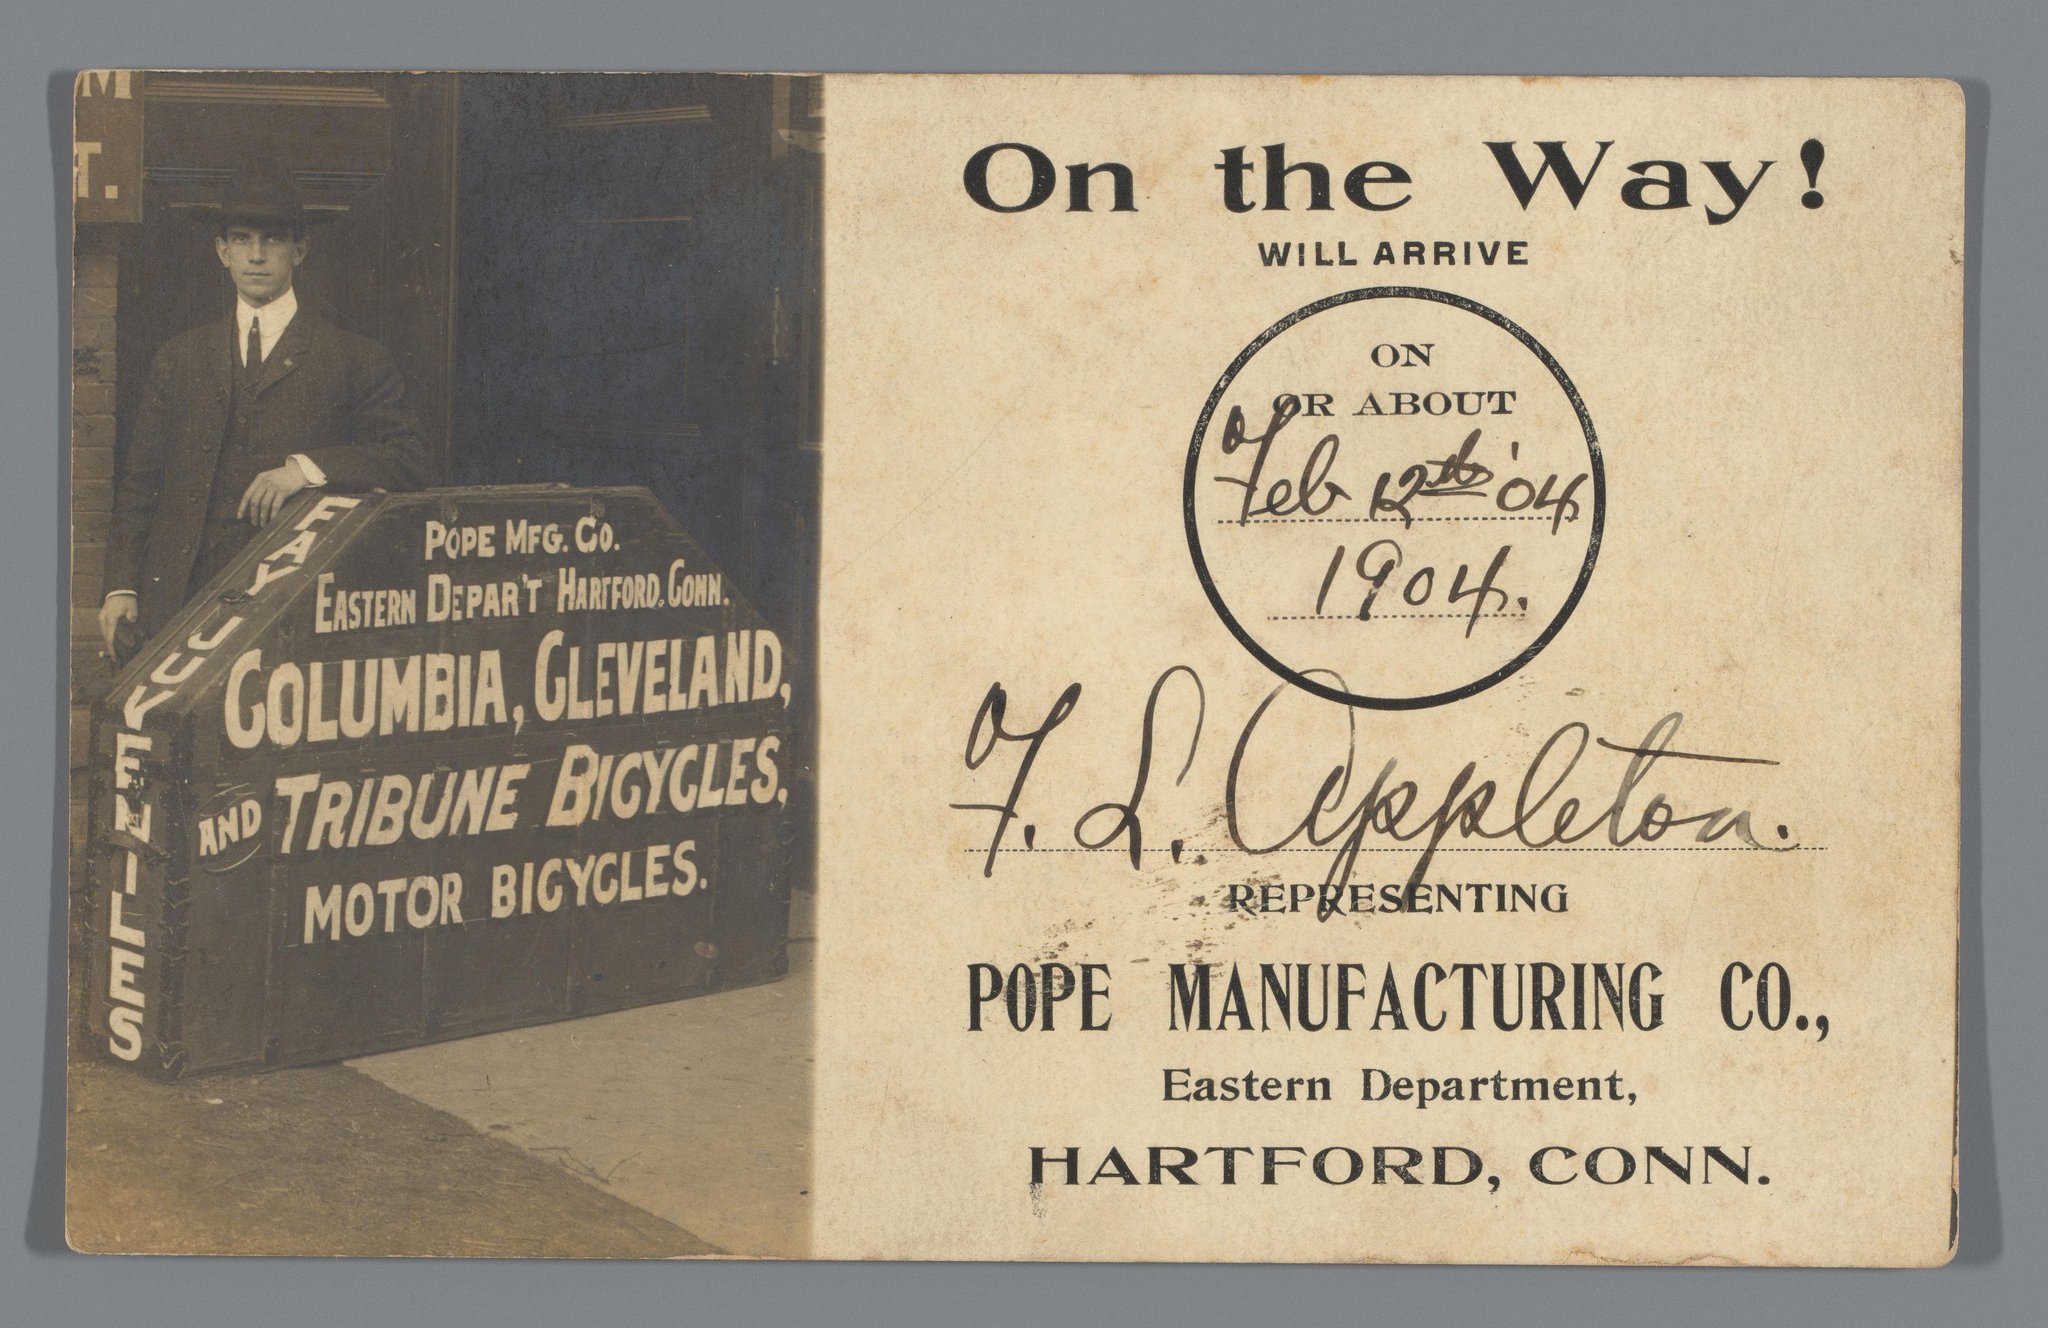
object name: ansichtkaart, prentbriefkaart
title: Reclame van een vertegenwoordiger van fietsen en motorfietsen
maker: Anonymous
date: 1904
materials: photographic support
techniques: photography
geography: united states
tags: united states of america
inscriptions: inscription: ‘On the Way! / WILL ARRIVE / ON / OR ABOUT / Feb 12th ’04 / 1904 / F. D. Appleton / REPRESENTING / POPE MANUFACTURING CO., / Eastern Department, / HARTFORD, CONN.’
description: Aankondiging van de komst van een vertegenwoordiger.